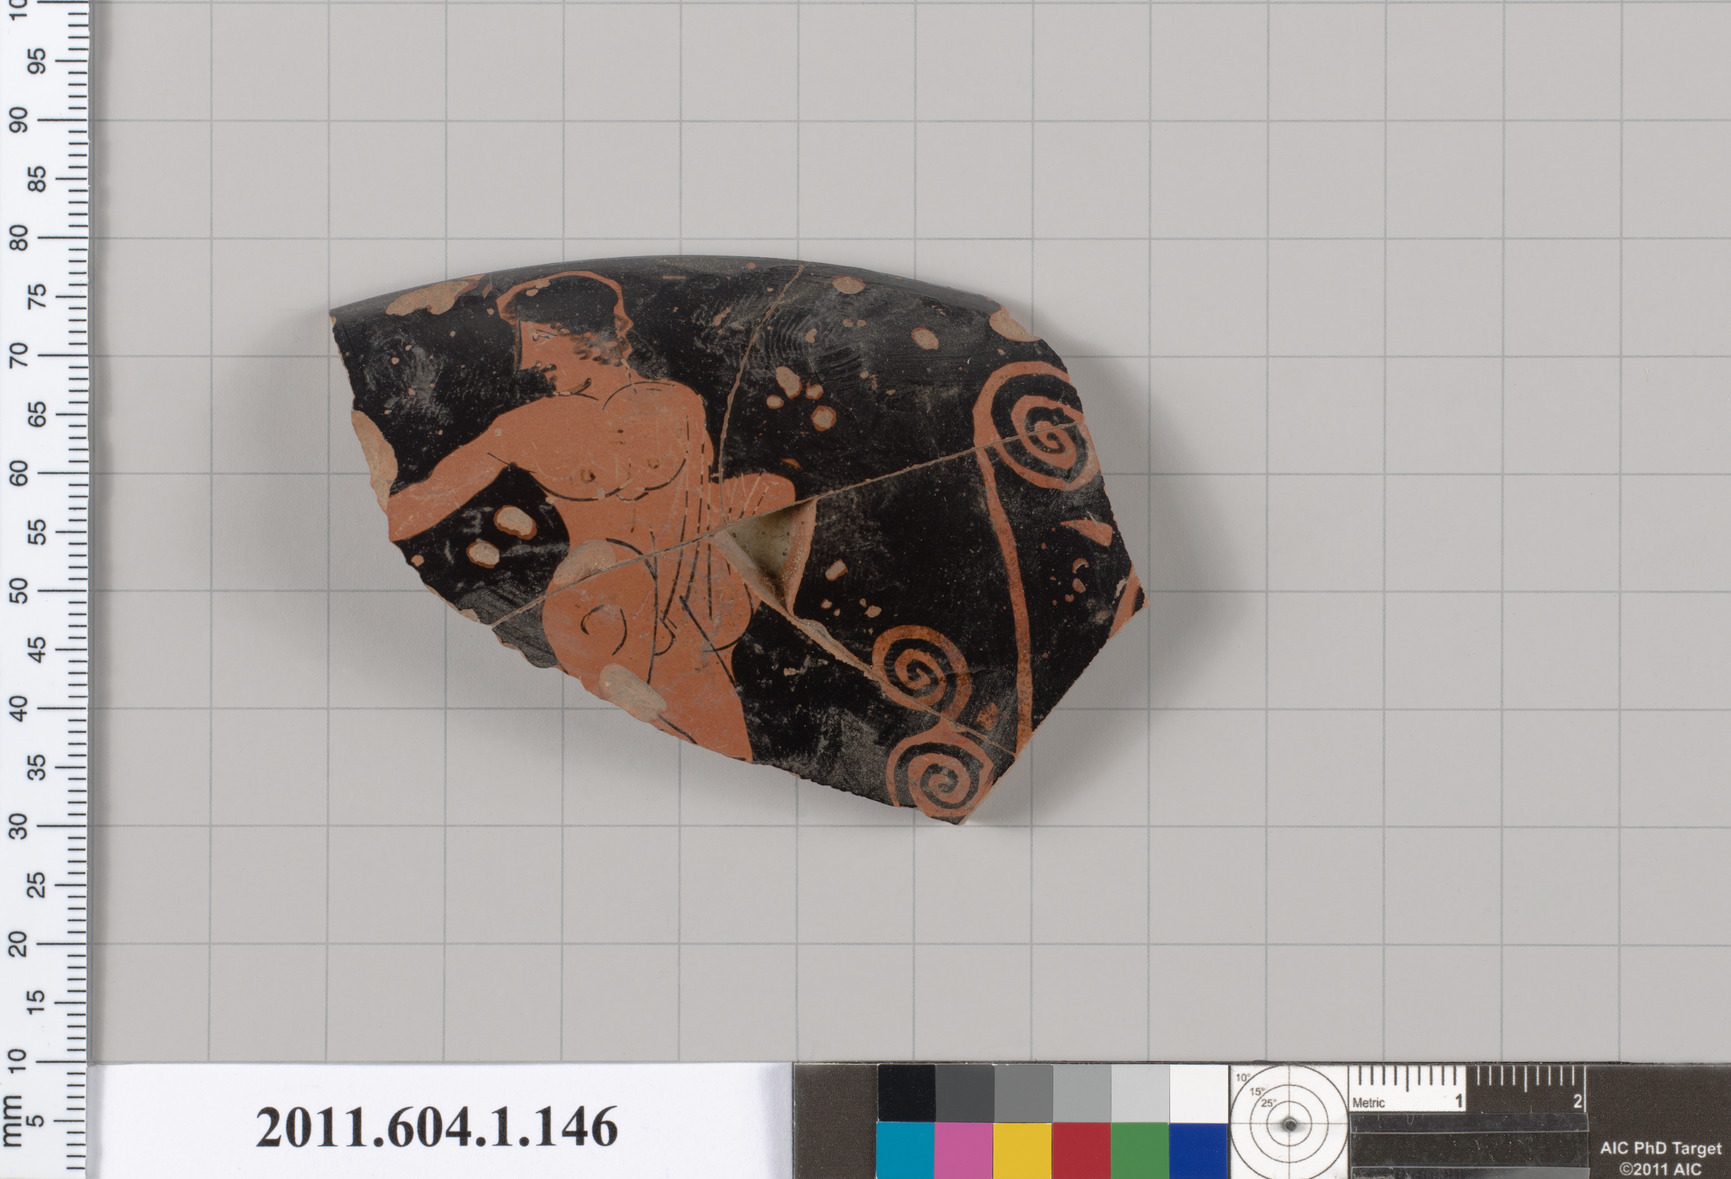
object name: kylix fragment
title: Terracotta rim fragment of a kylix (drinking cup)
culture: greek, attic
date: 475-451 BCE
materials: terracotta